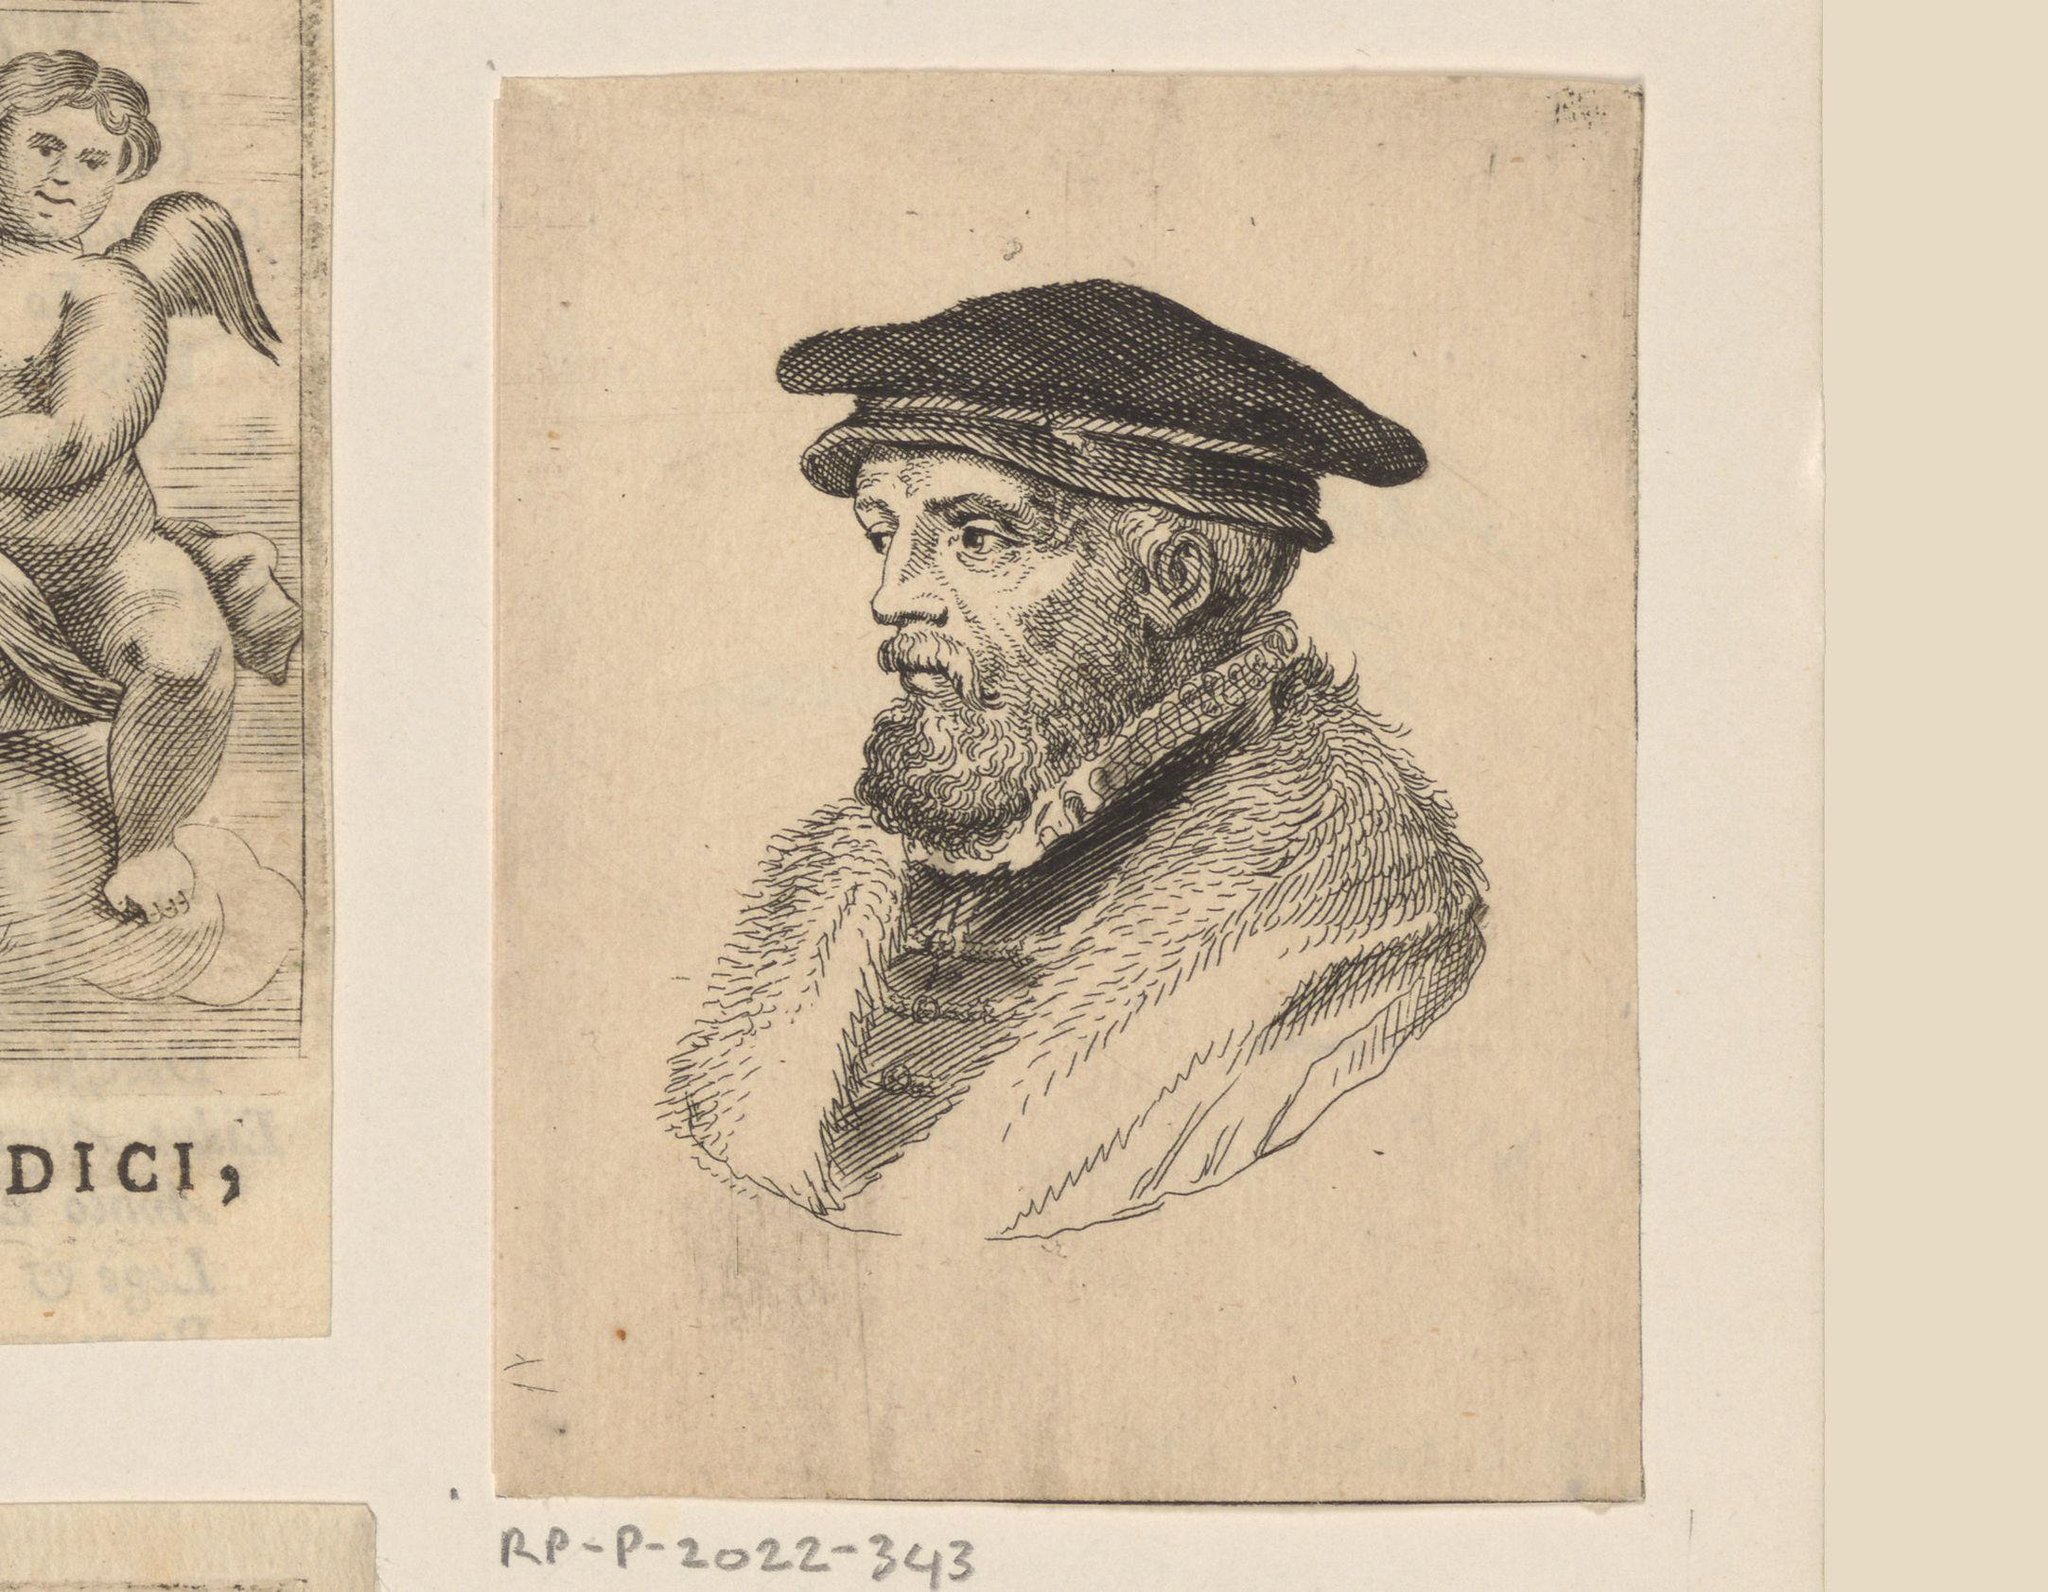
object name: print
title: Portret van Hadrianus Junius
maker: Anonymous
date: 1600-1649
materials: paper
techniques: etching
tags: hoorn (north holland), middelburg, hadrianus junius, historical persons, physician, doctor